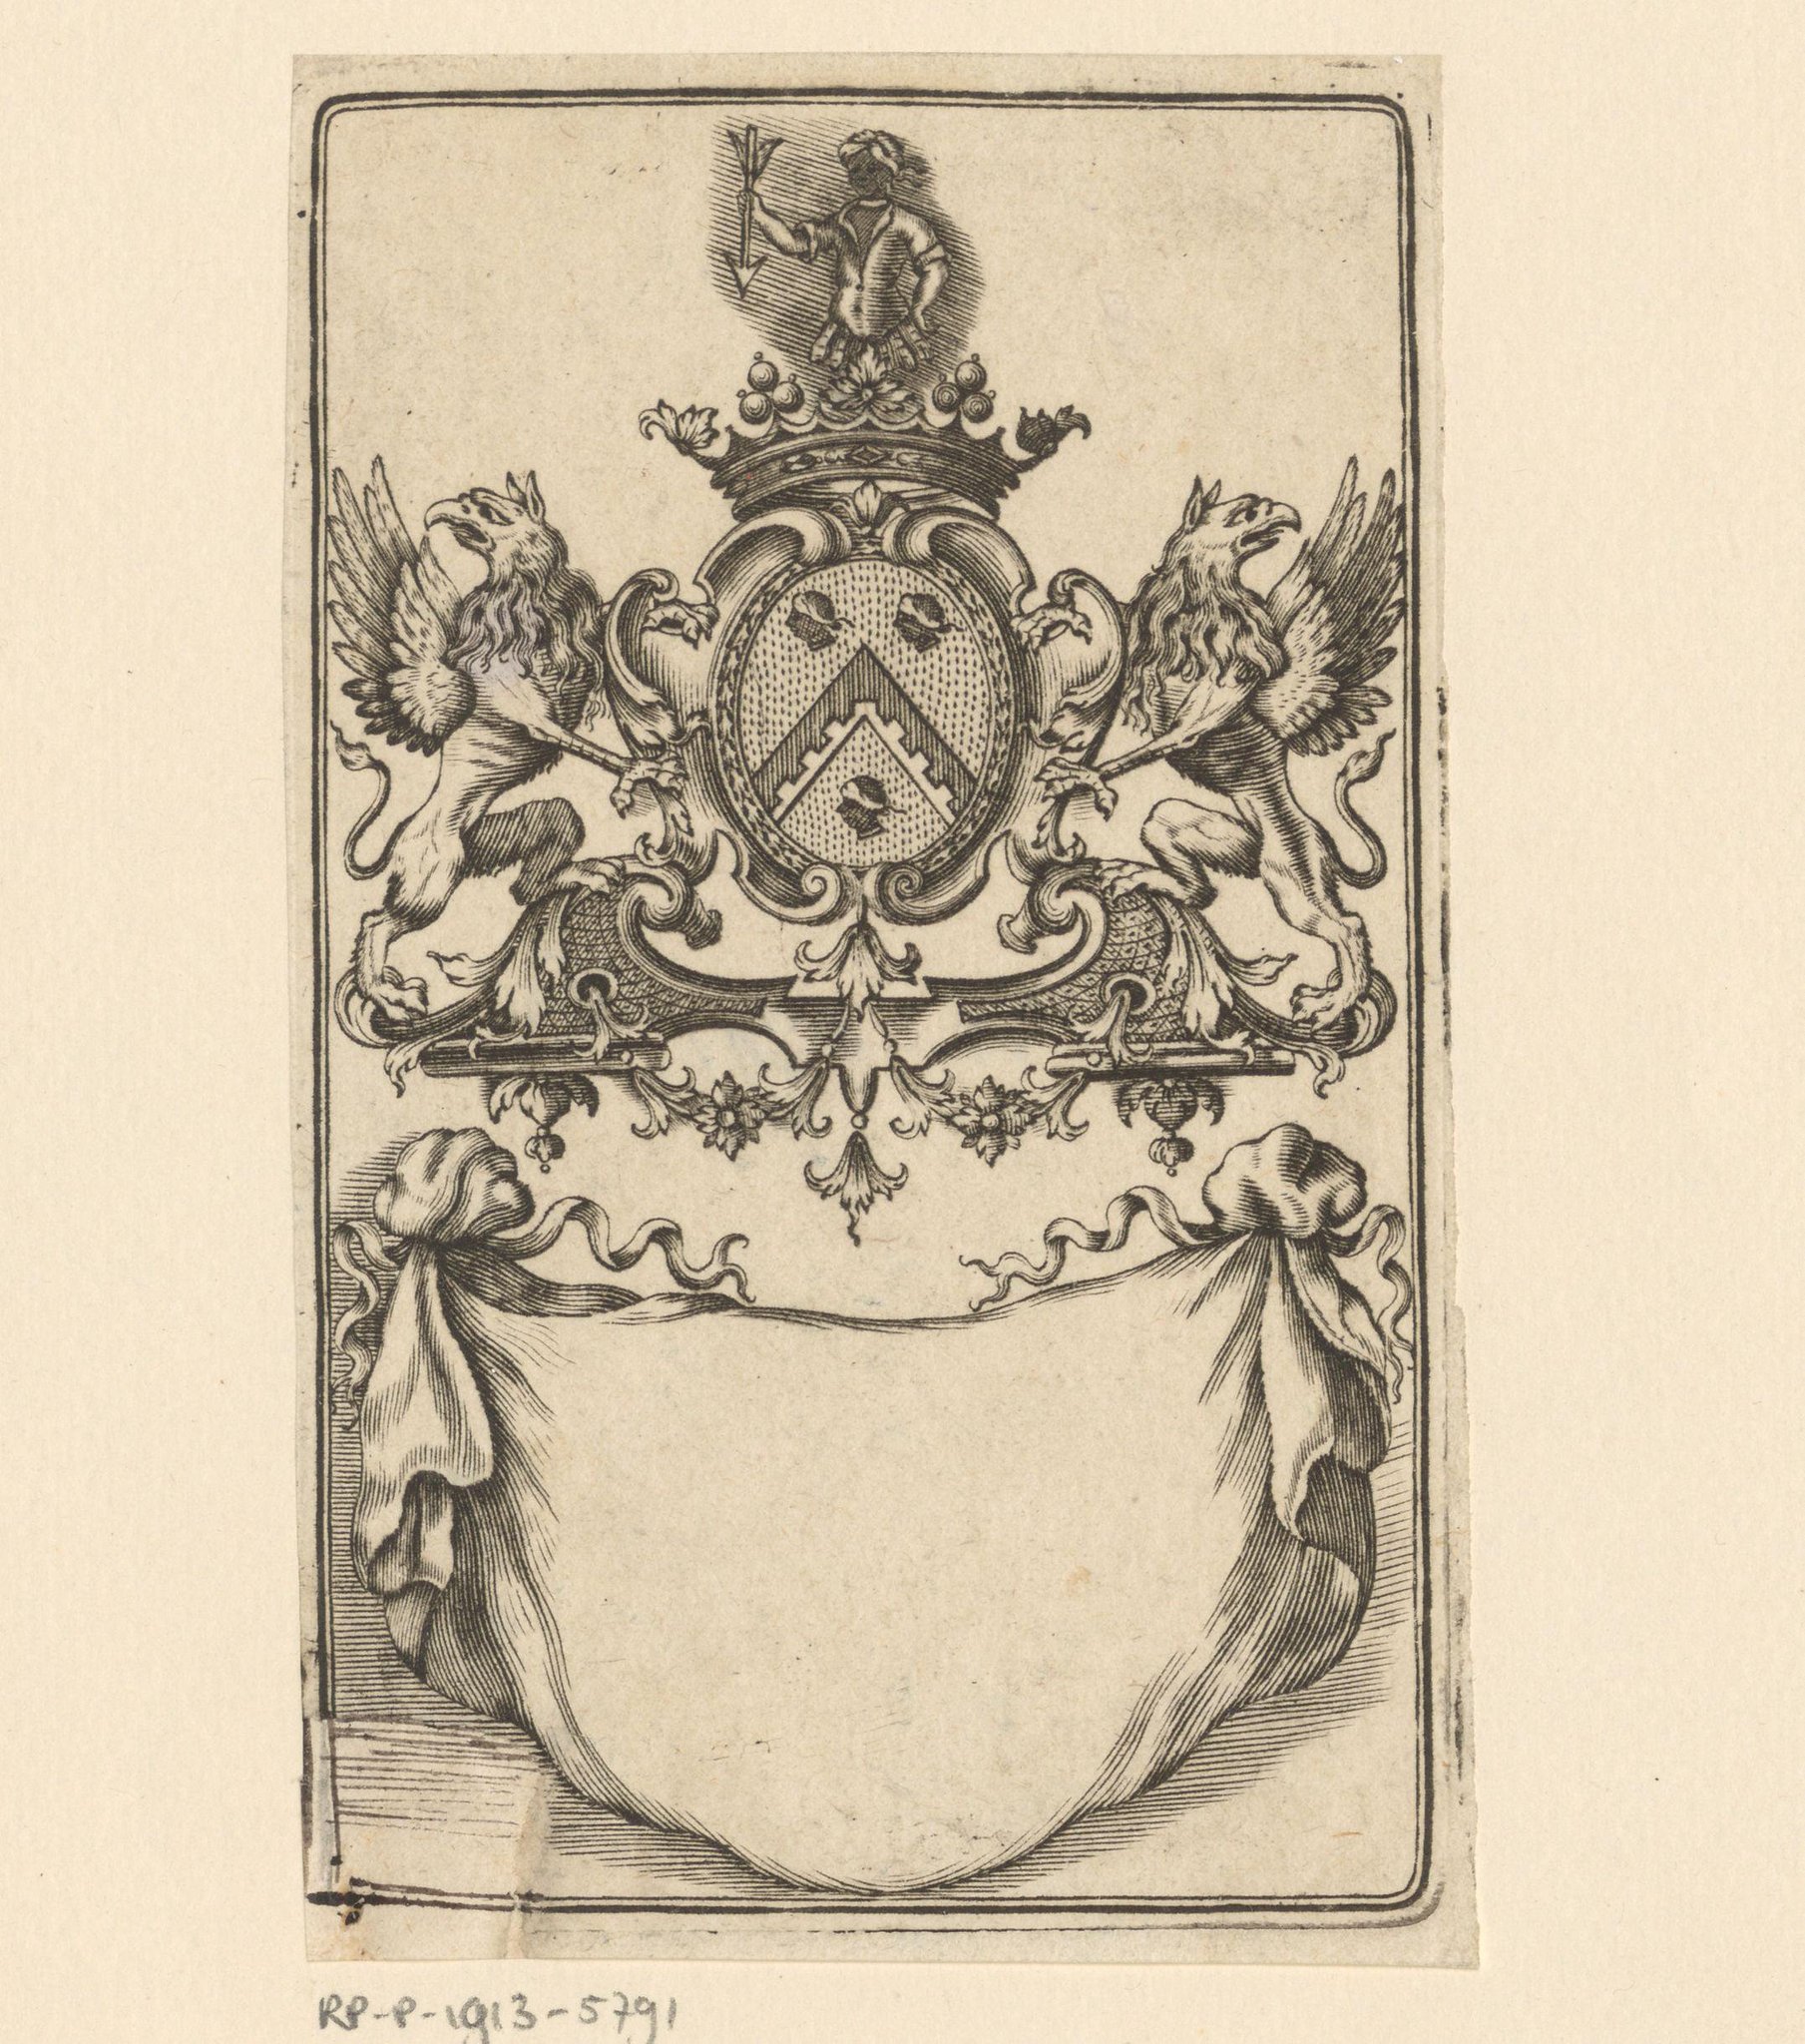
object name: bookplate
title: Ex libris van onbekend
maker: Anonymous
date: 1650-1800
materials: paper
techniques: engraving, etching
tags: standing figure, griffin (lion/eagle); 'griffo' (ripa), archer's weapons: arrow, armorial bearing, heraldry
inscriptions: collector's mark: Lugt 2233, collector's mark: Lugt 2760